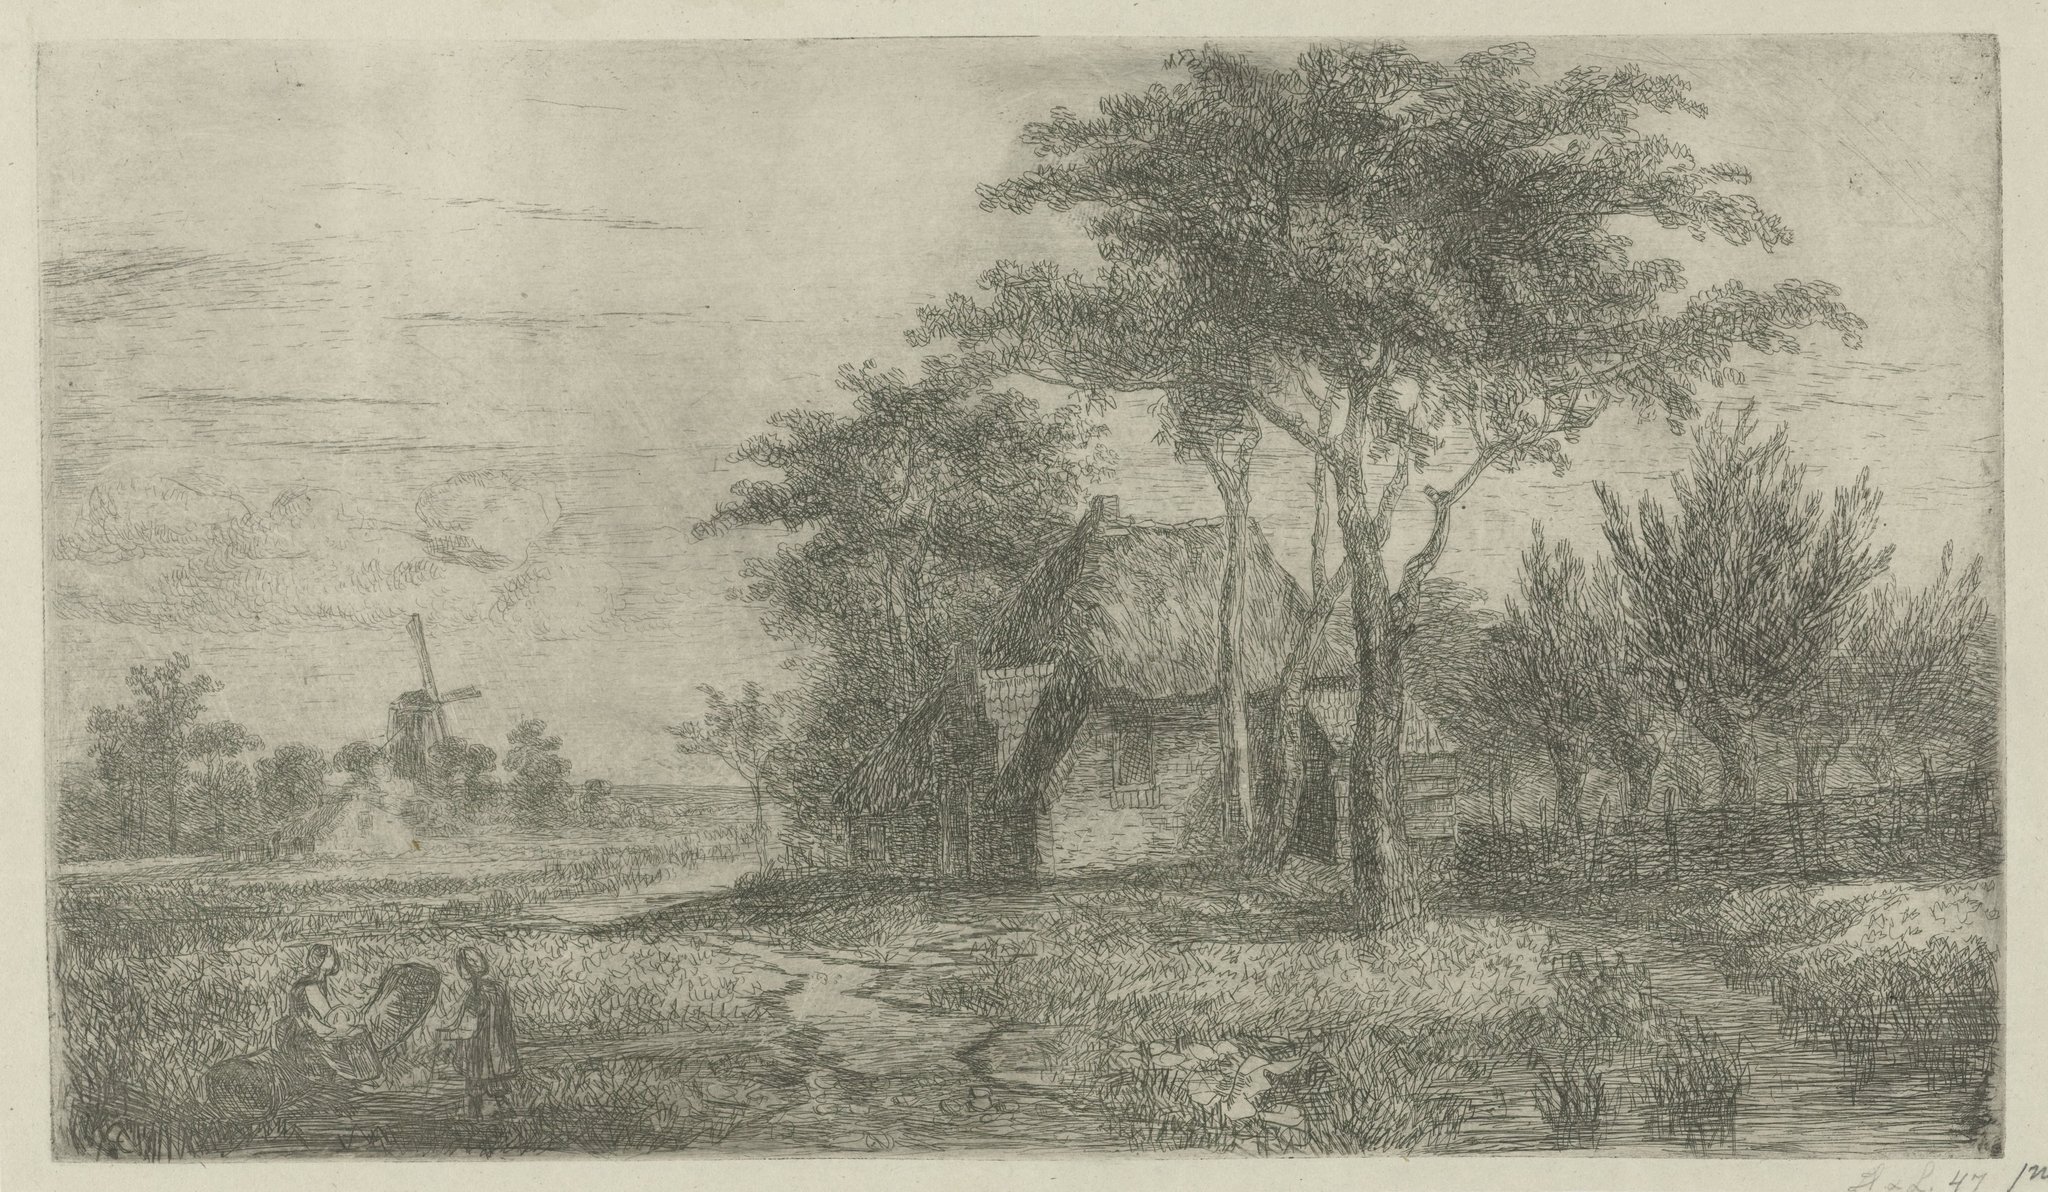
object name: print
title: Landschap met een wandelaar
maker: hermanus jan hendrik van rijkelijkhuysen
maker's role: painter, print maker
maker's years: 1813-1883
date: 1857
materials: paper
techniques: etching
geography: utrecht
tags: trees, windmill, 'en route', traveller under way, farm or solitary house in landscape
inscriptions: collector's mark: Lugt 2228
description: Een vlak landschap met op de voorgrond een wandelaar die mogelijk de weg vraagt. Rechts een boerenhoeve aan een stroompje en op de achtergrond een windmolen.